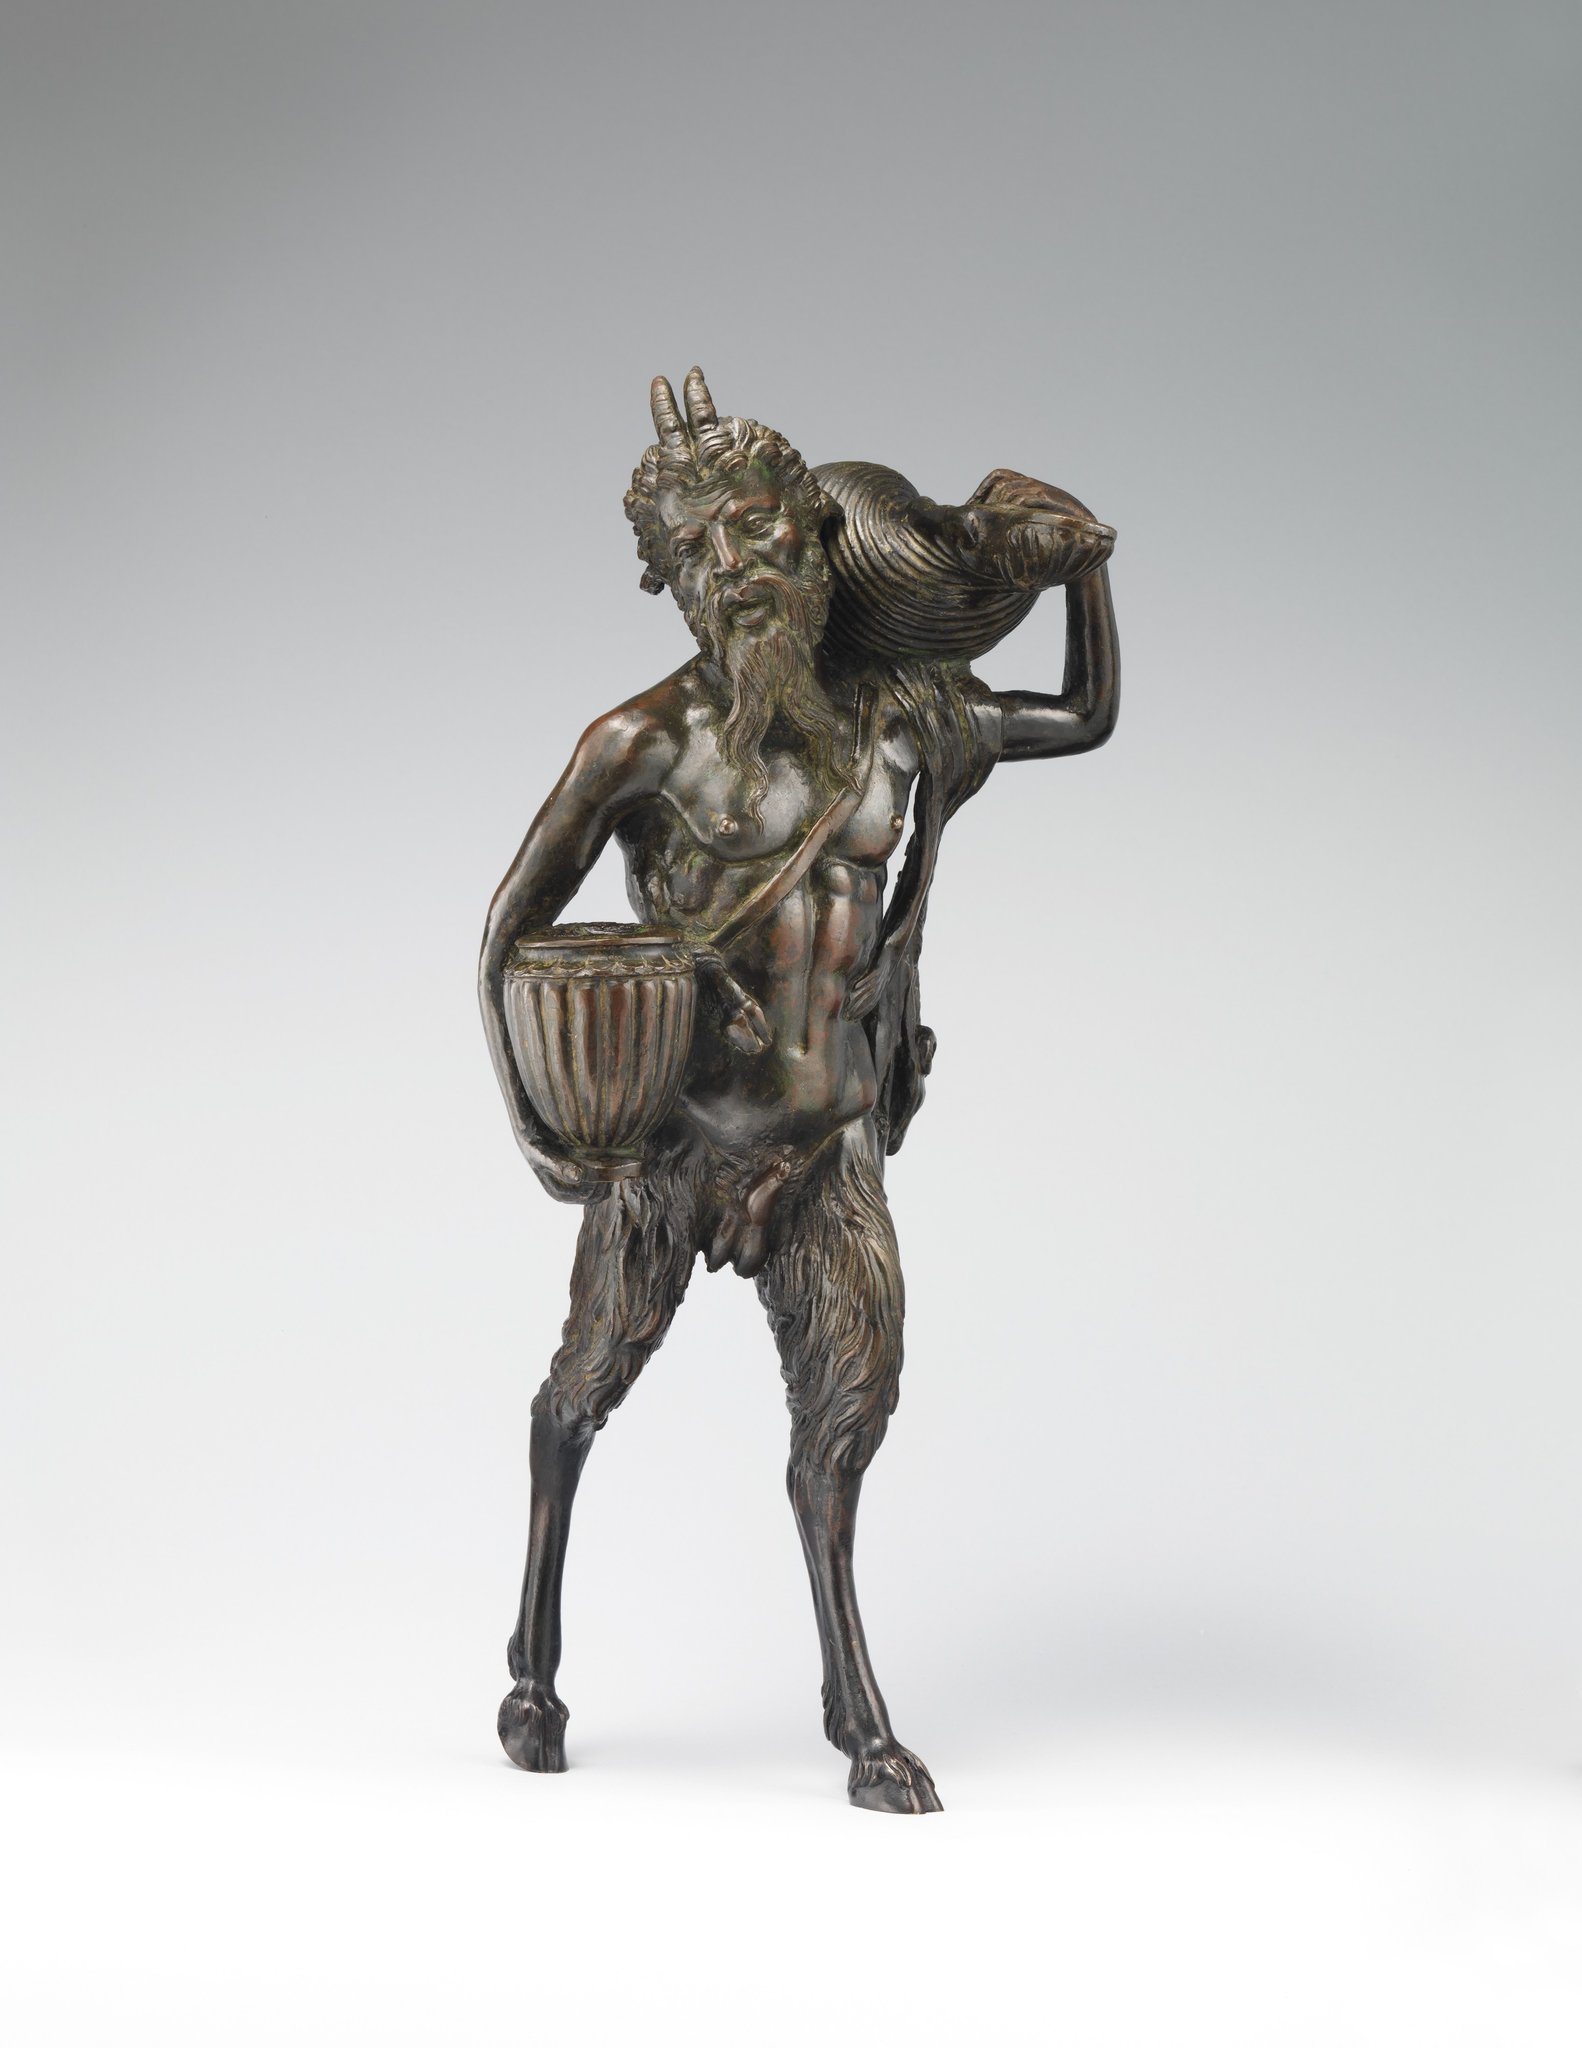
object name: statuette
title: Striding Pan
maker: andrea briosco, called riccio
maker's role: artist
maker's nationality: italian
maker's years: 1470-1532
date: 1530-1539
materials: bronze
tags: satyrs